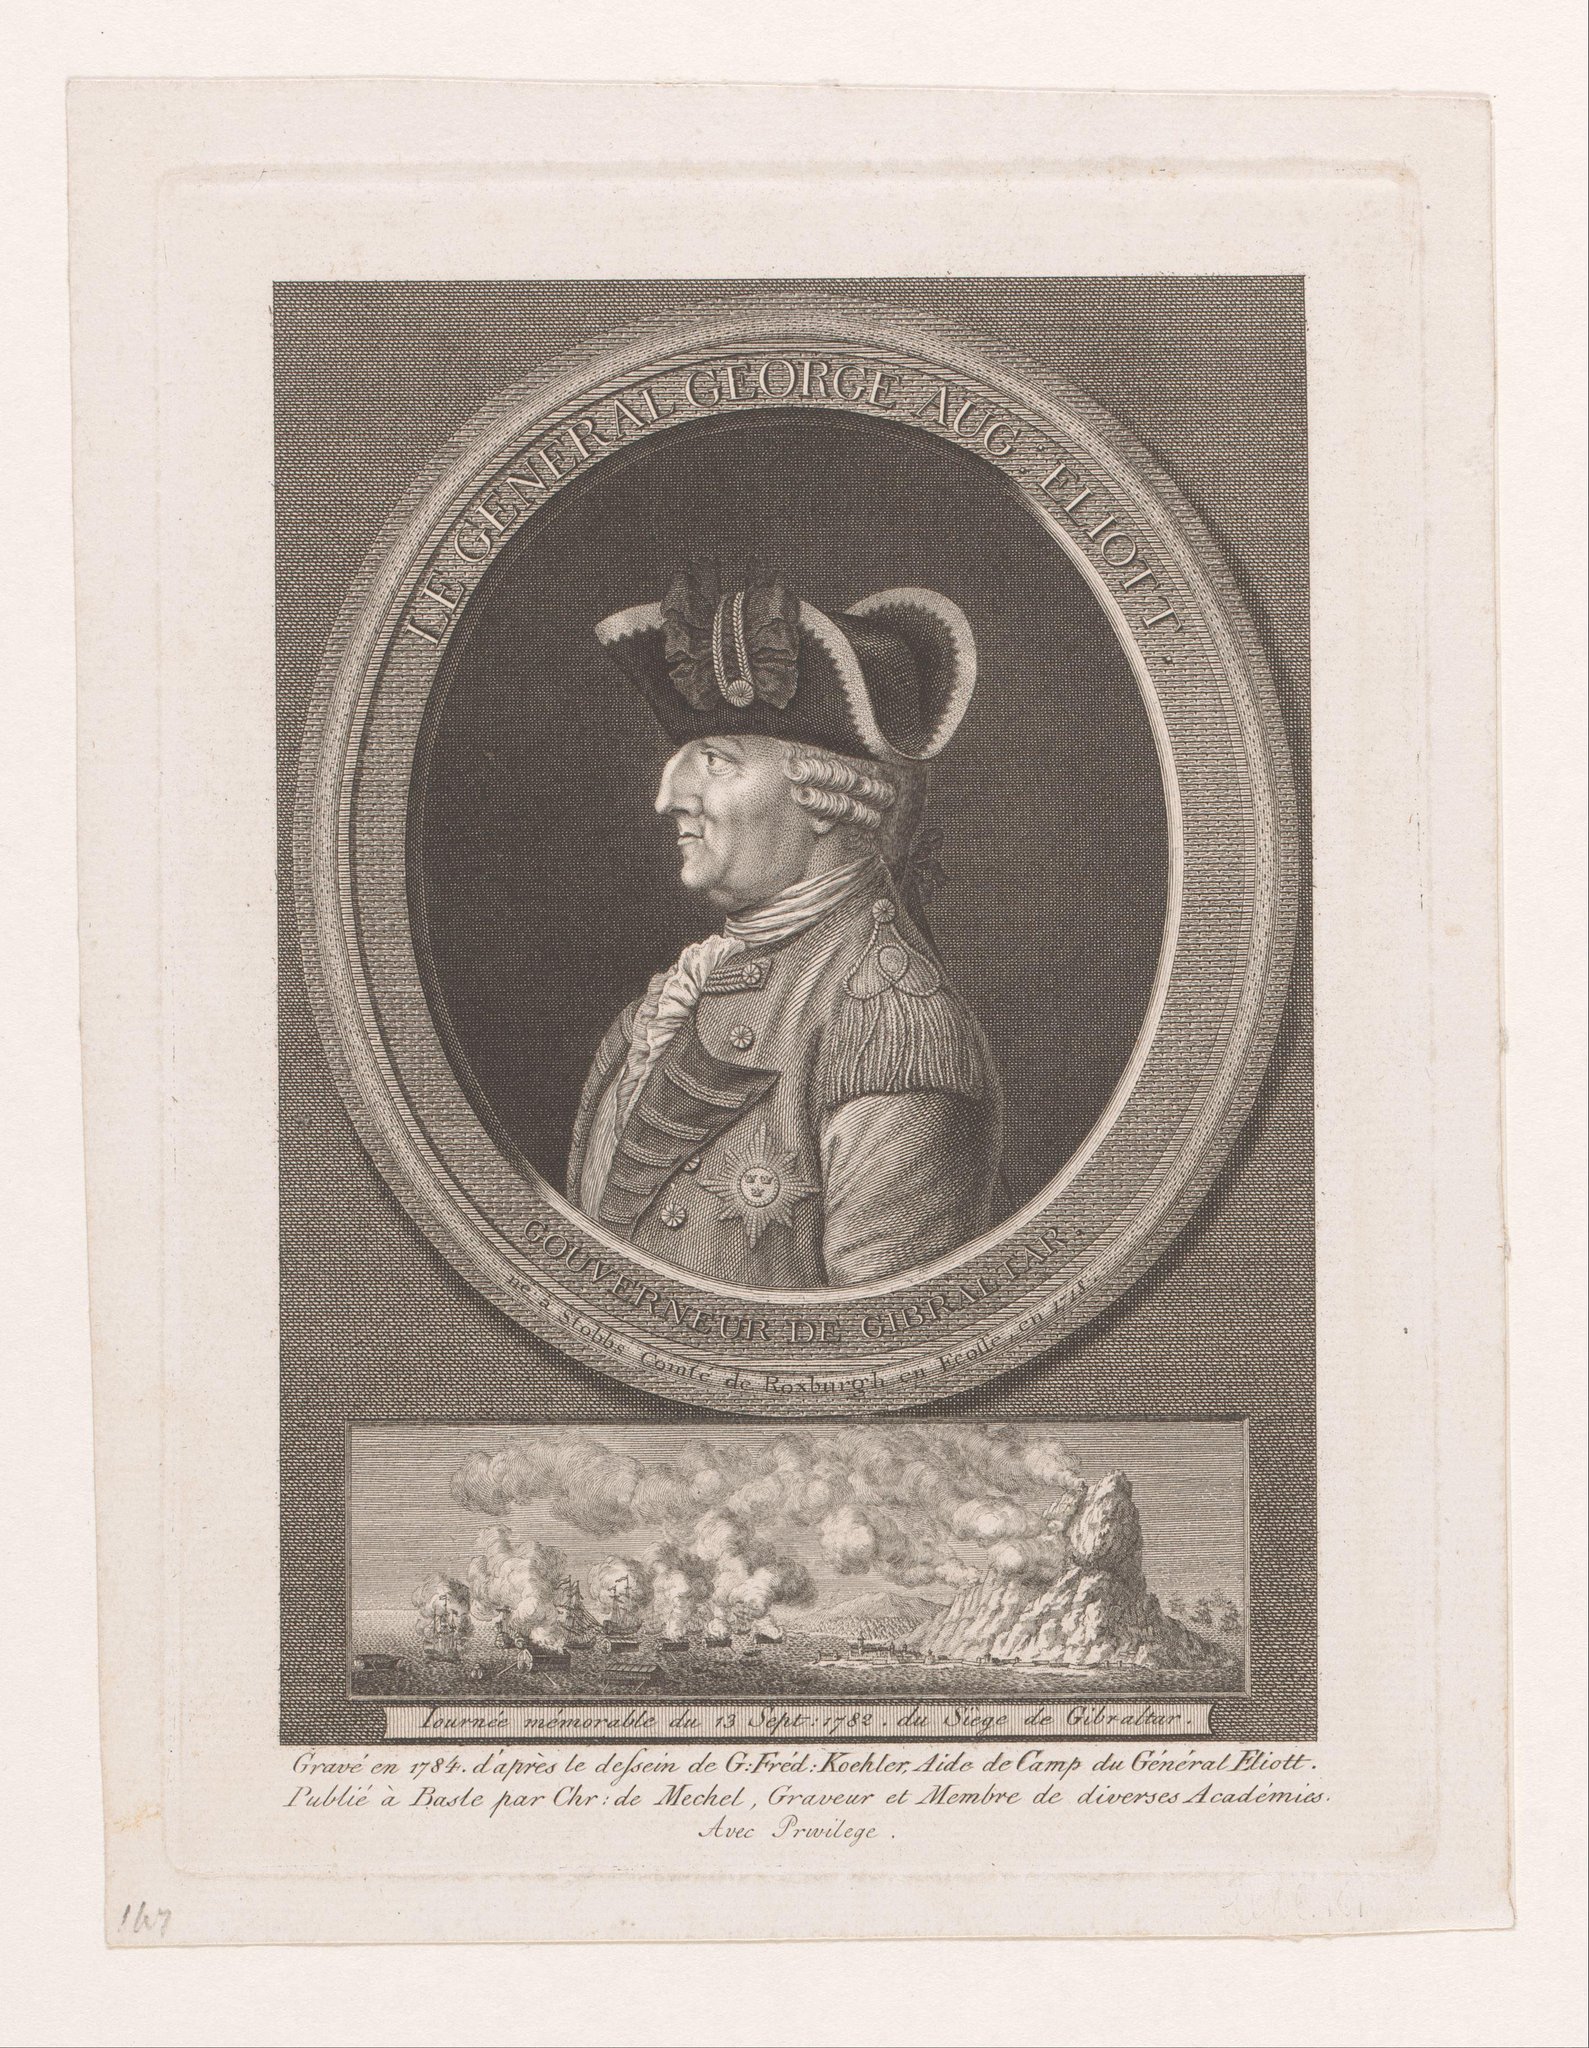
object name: print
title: Portret van generaal George Eliott met Zeeslag bij Gibraltar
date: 1784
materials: paper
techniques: etching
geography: basel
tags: commander-in-chief, general, marshal, battle (+ naval force)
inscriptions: collector's mark: Lugt 2228